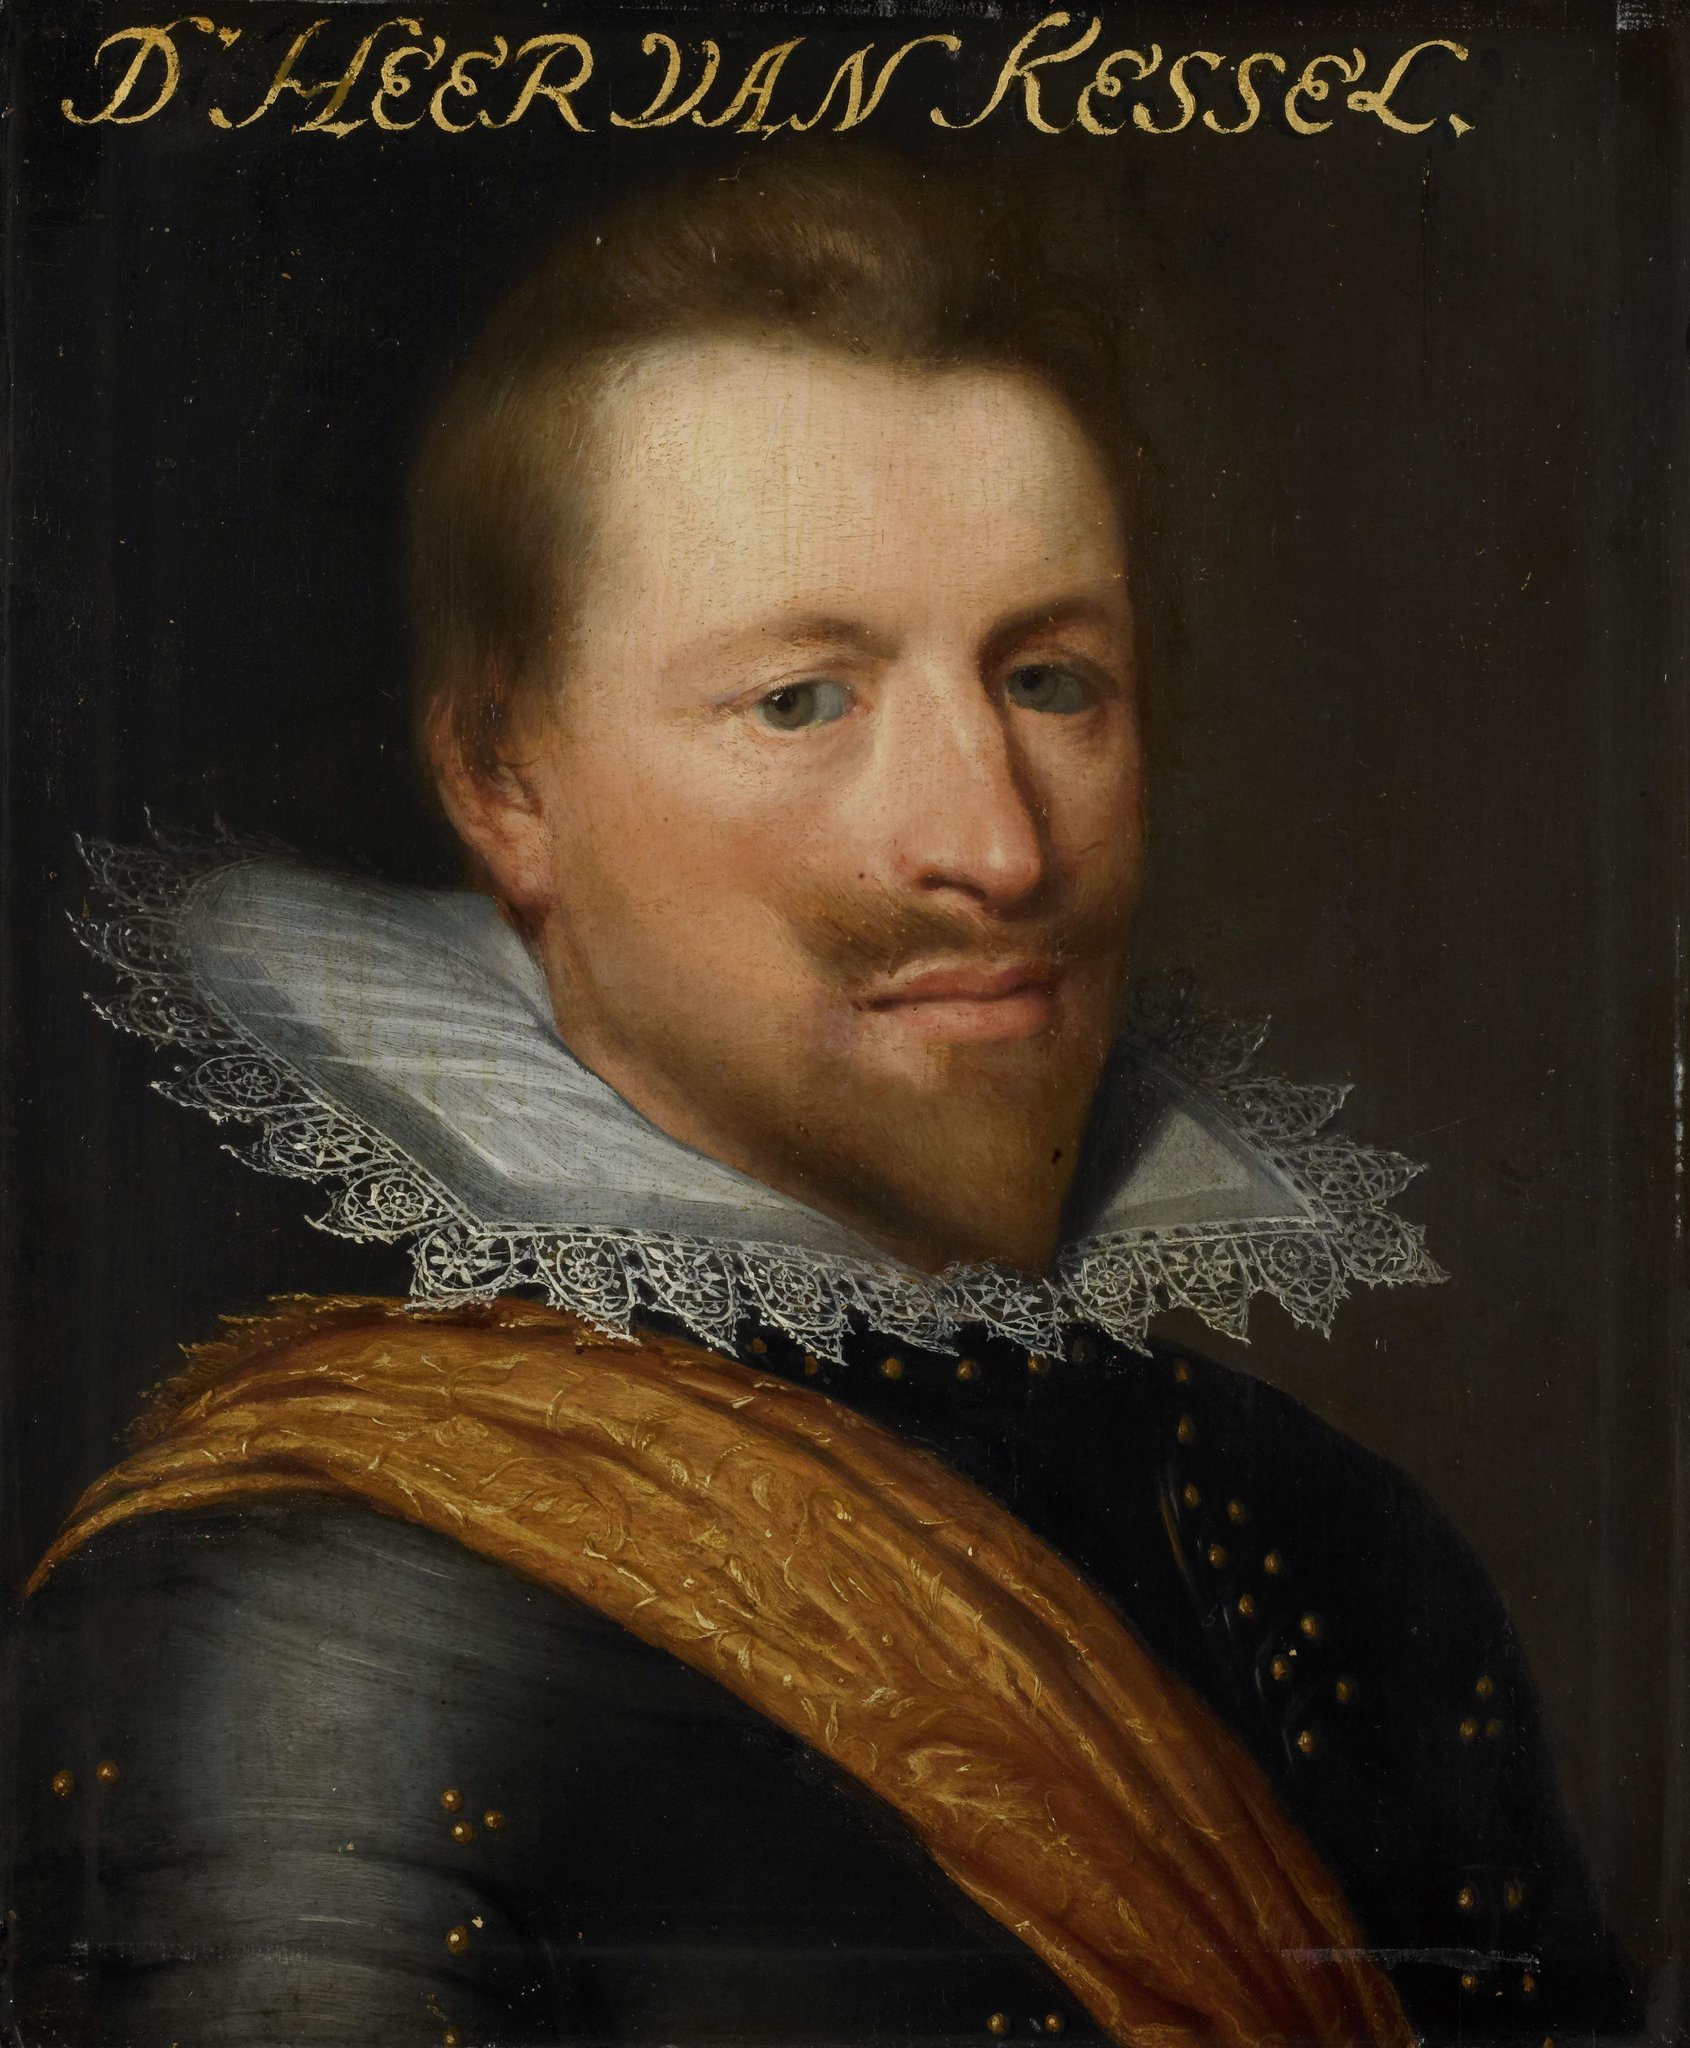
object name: painting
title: Portrait of Willem Adriaen (?-1625), Count of Hornes, Lord of Kessel and Westwezel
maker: jan antonisz van ravesteyn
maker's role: draughtsman, painter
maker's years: 1570-1657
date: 1616-1633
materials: oil, panel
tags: historical persons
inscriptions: inscription, top: ‘D'Heer van Kessel’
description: Willem Adriaan, graaf van Hornes, heer van Kessel en Westwezel (?-1625), naar J.A. van Ravesteyn.